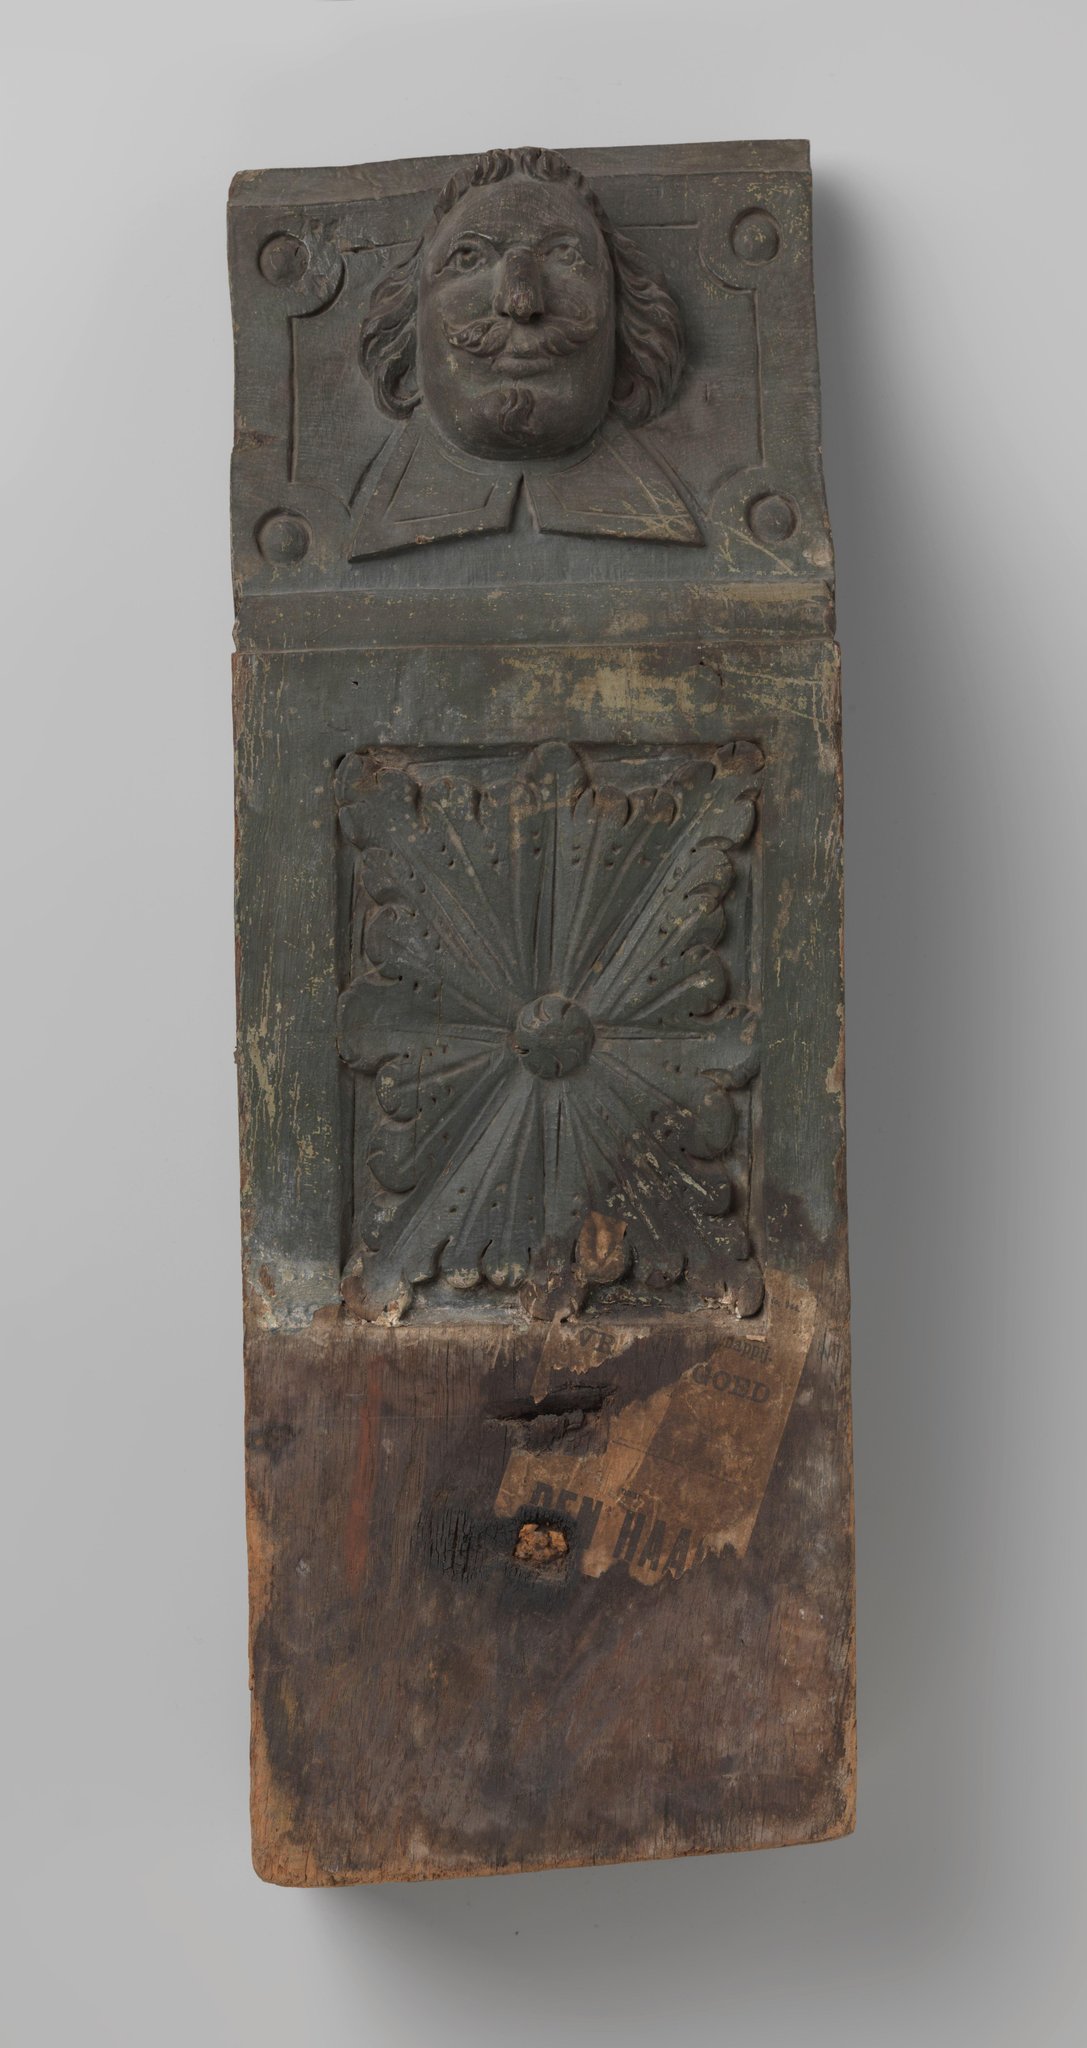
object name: sculpture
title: Balksleutel met mannenkop.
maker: Anonymous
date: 1500-1599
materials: iron, wood, paint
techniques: painted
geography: northern netherlands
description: Balksleutel van grijsachtig groen geschilderd eikenhout; op de dagkant is een mannenkop afgebeeld.